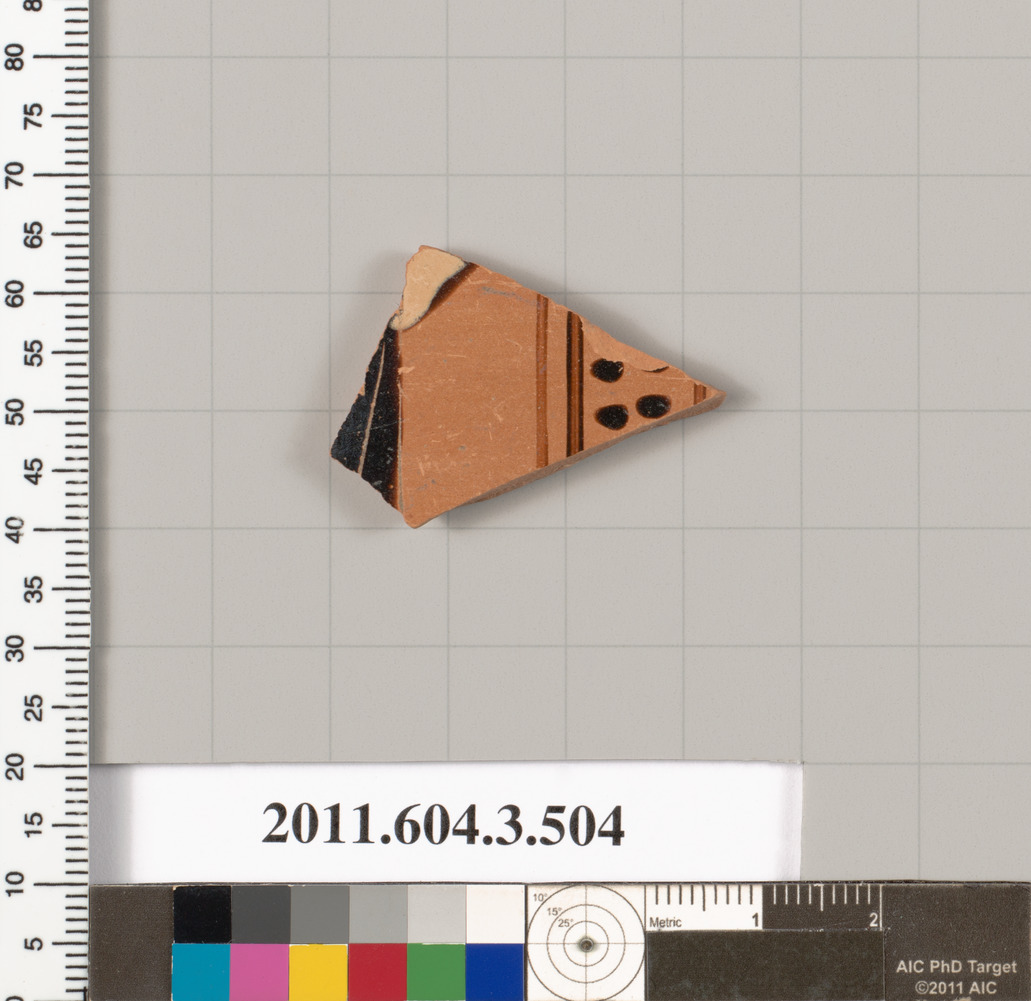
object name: column krater fragment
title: Terracotta fragment of a column-krater (bowl for mixing wine and water)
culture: greek, attic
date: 550-526 BCE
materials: terracotta